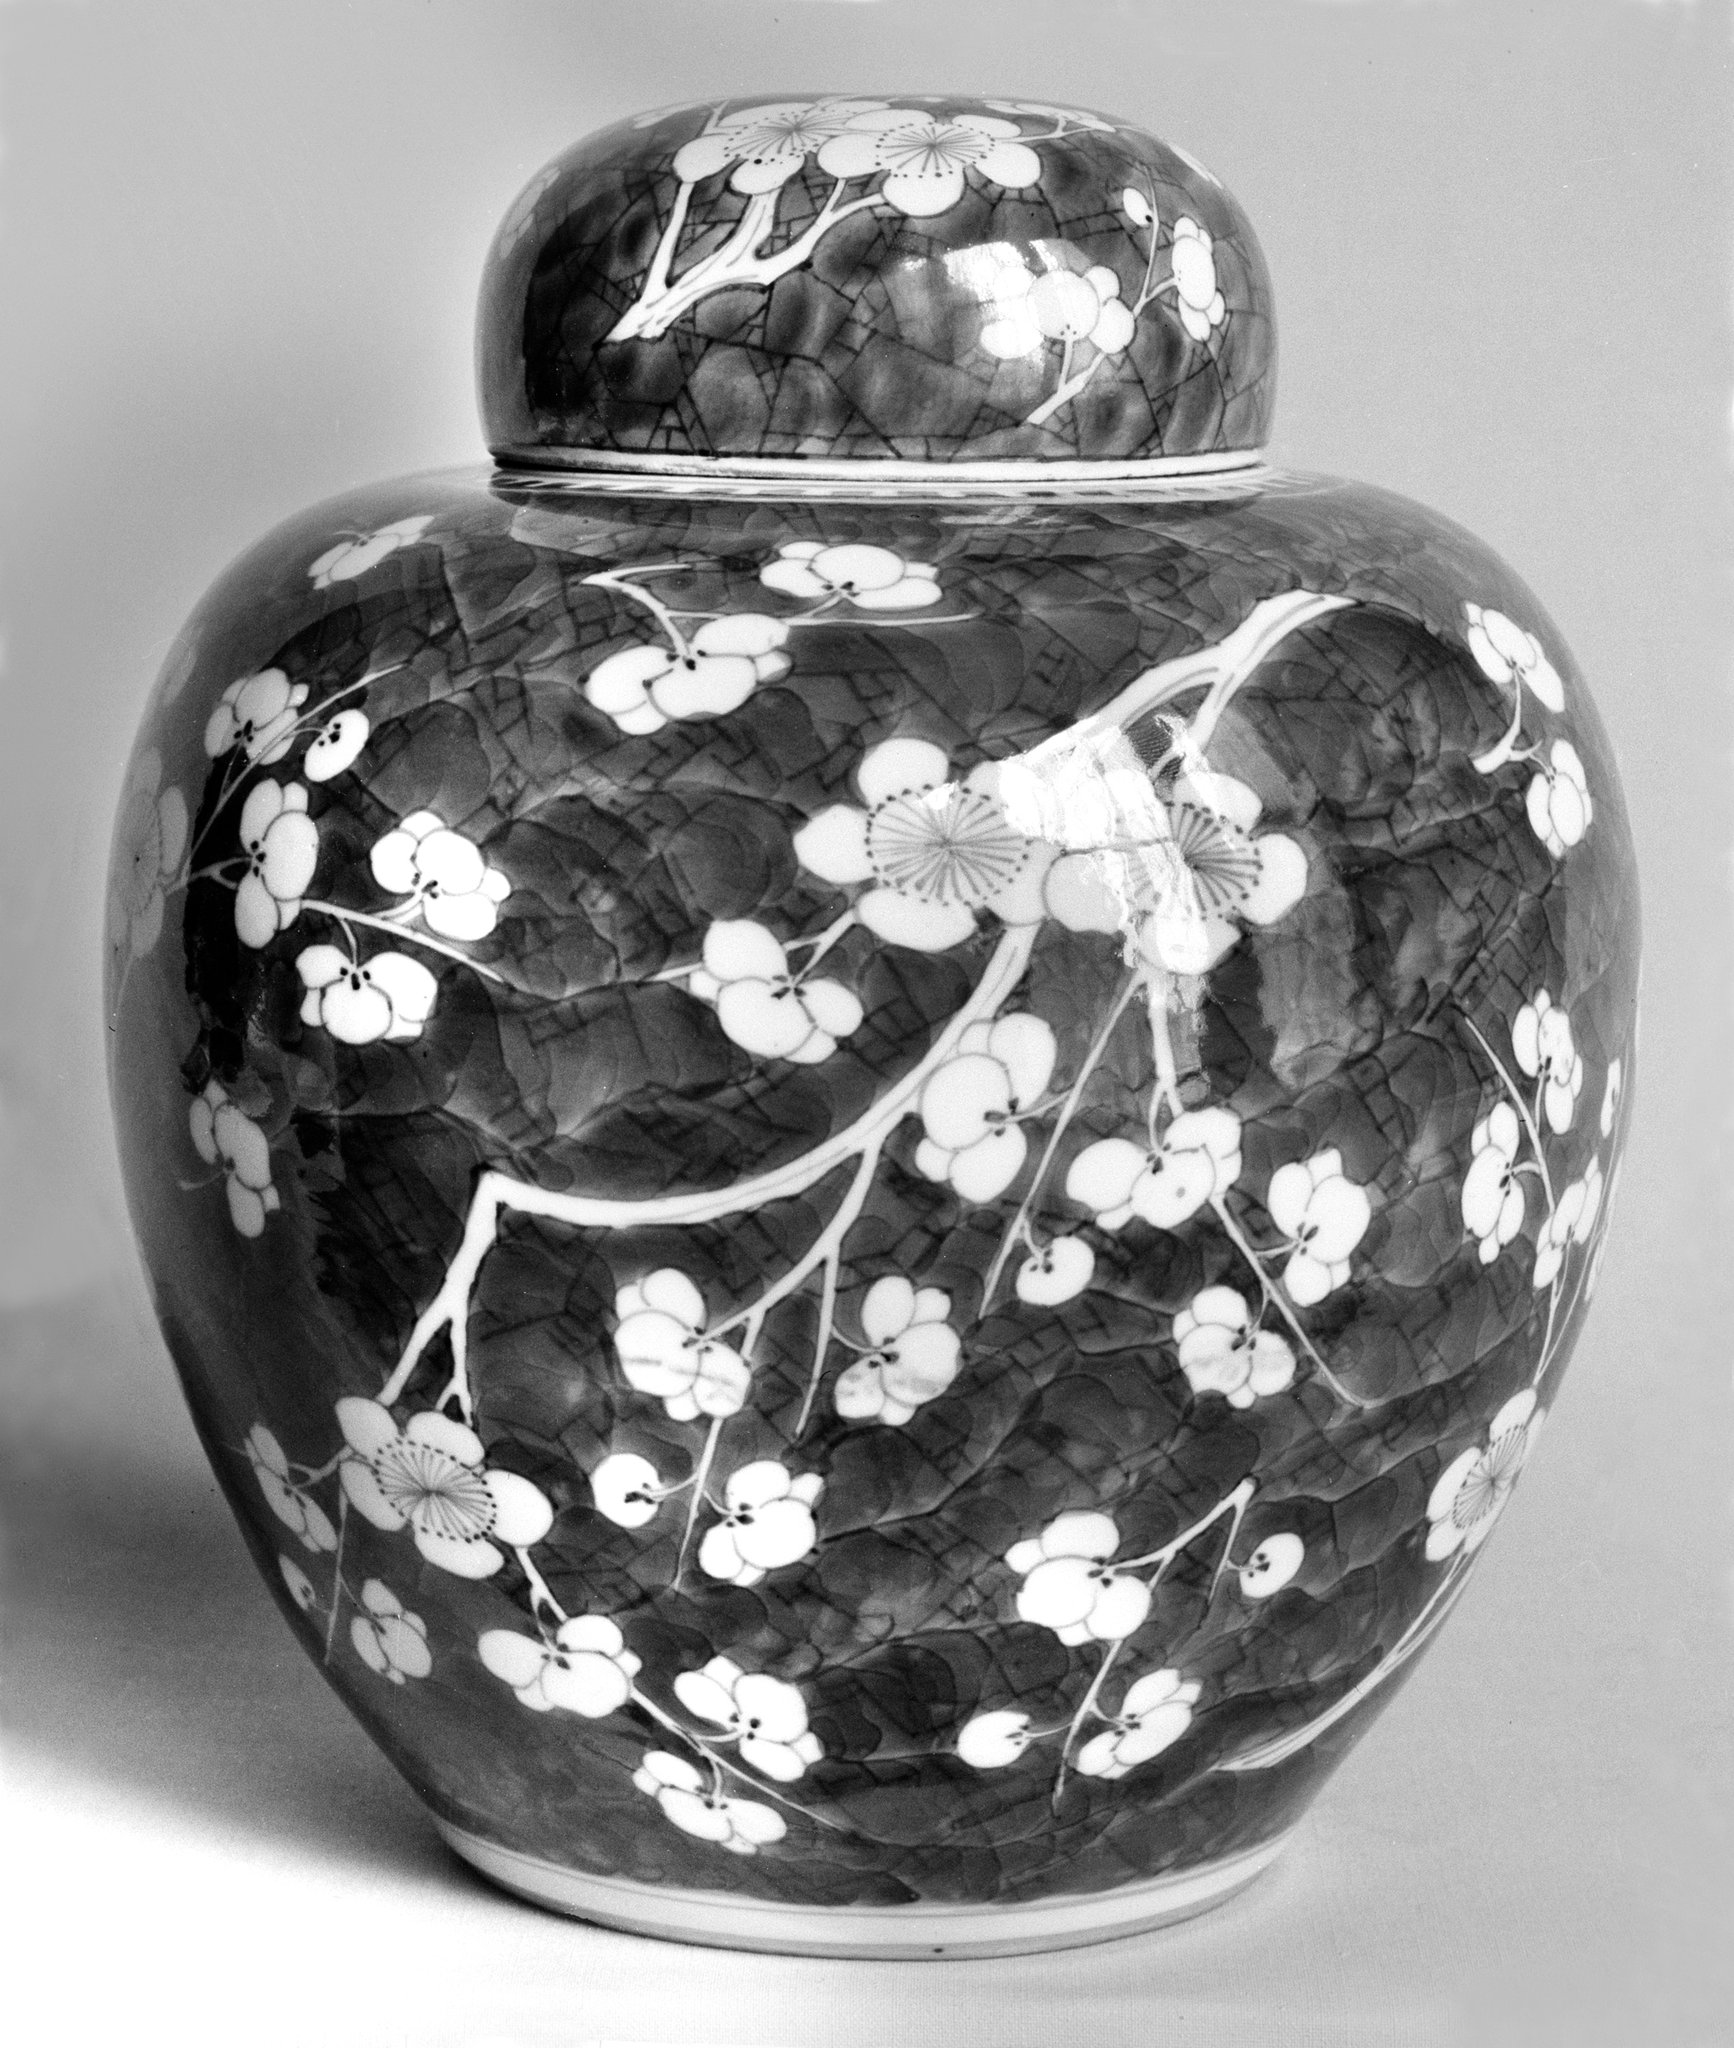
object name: jar with cover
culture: chinese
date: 1661-1722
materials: porcelain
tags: flowers